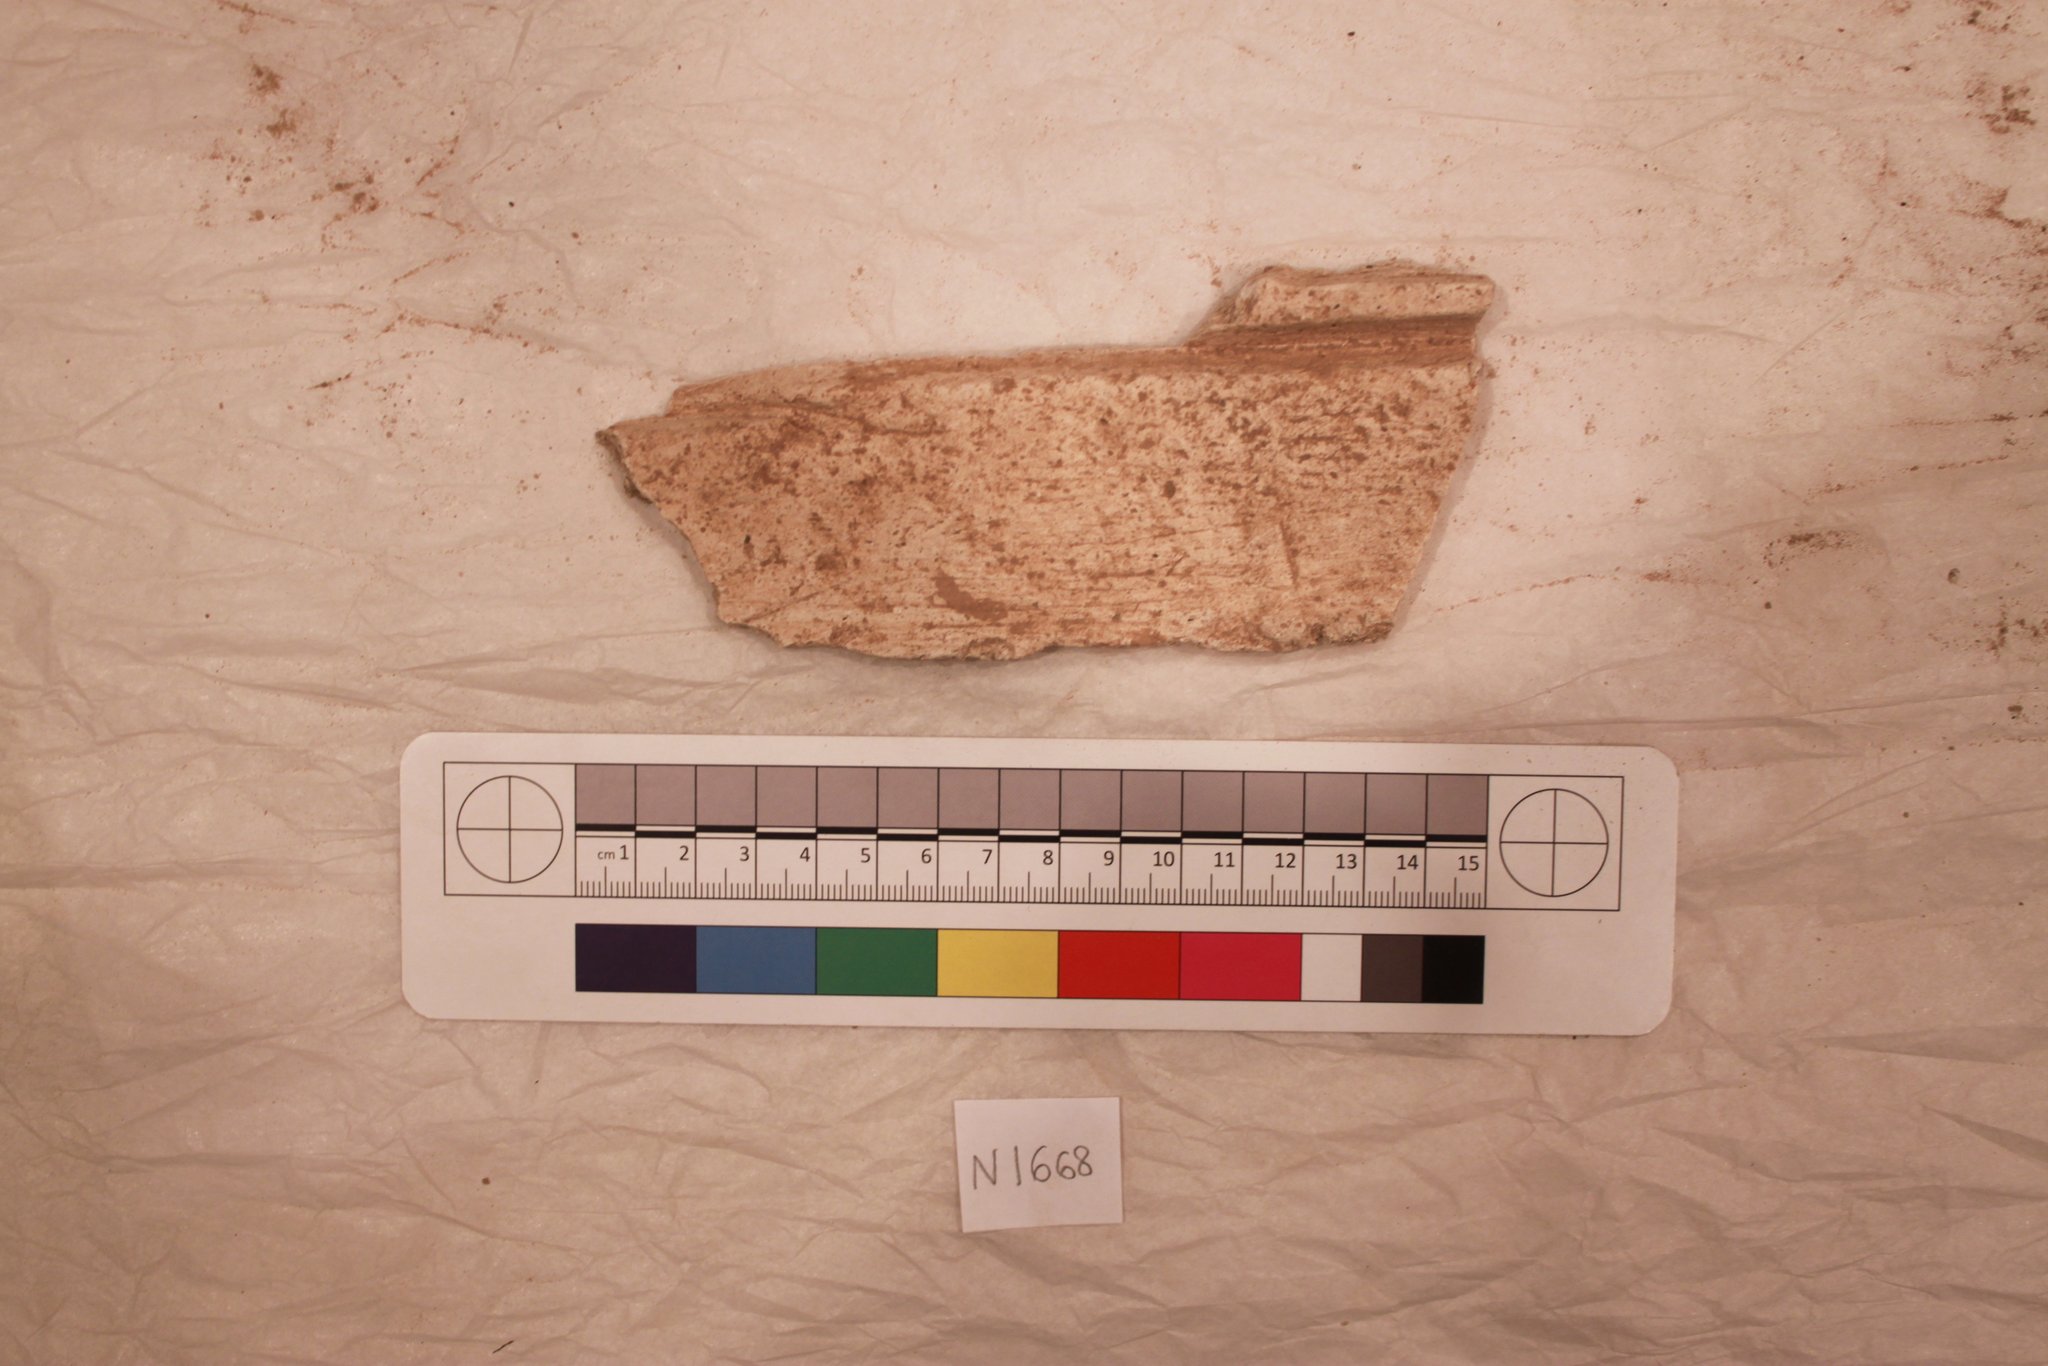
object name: fragment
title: Stucco Fragment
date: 701-1200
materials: plaster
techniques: carving, painting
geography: iran